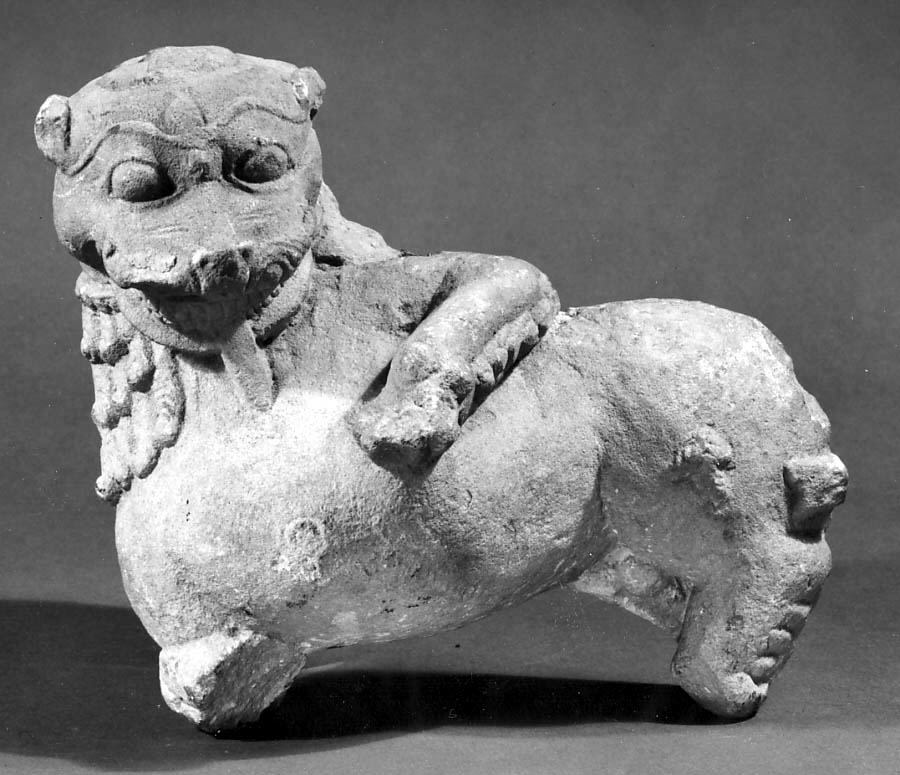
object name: figure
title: Lion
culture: indian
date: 1201-1300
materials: stone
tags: lions